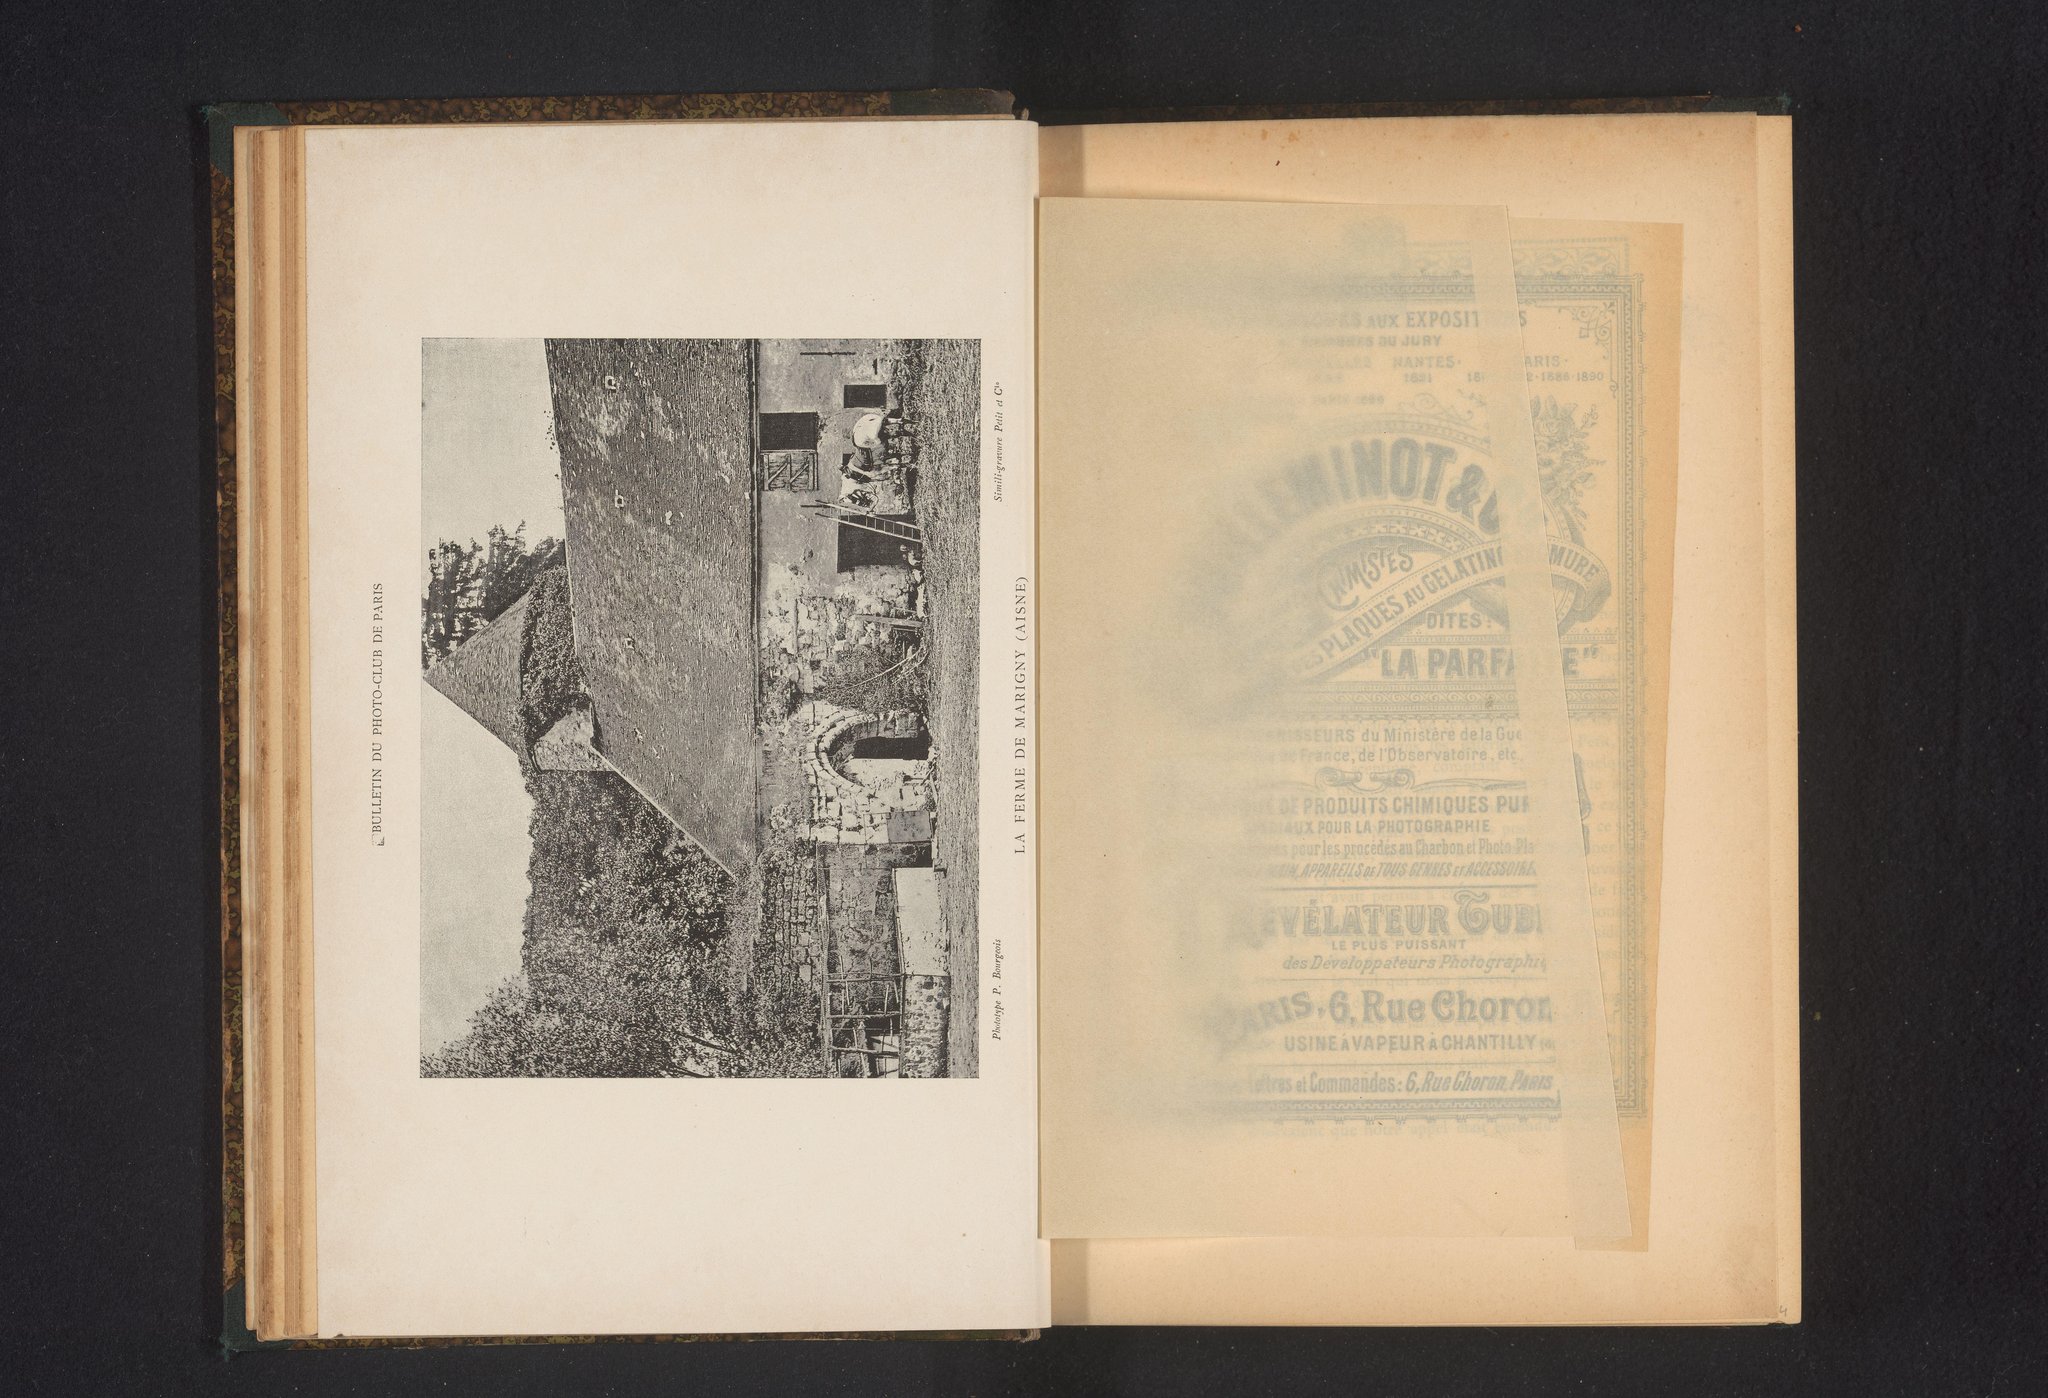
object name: photomechanical print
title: La Ferme de Marigny (Aisne)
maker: paul bourgeois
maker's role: fotograaf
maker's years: -1929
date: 1890-1895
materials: paper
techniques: autotype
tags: farm (building)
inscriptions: inscription: ‘Bulletin du Photo-Club de Paris’